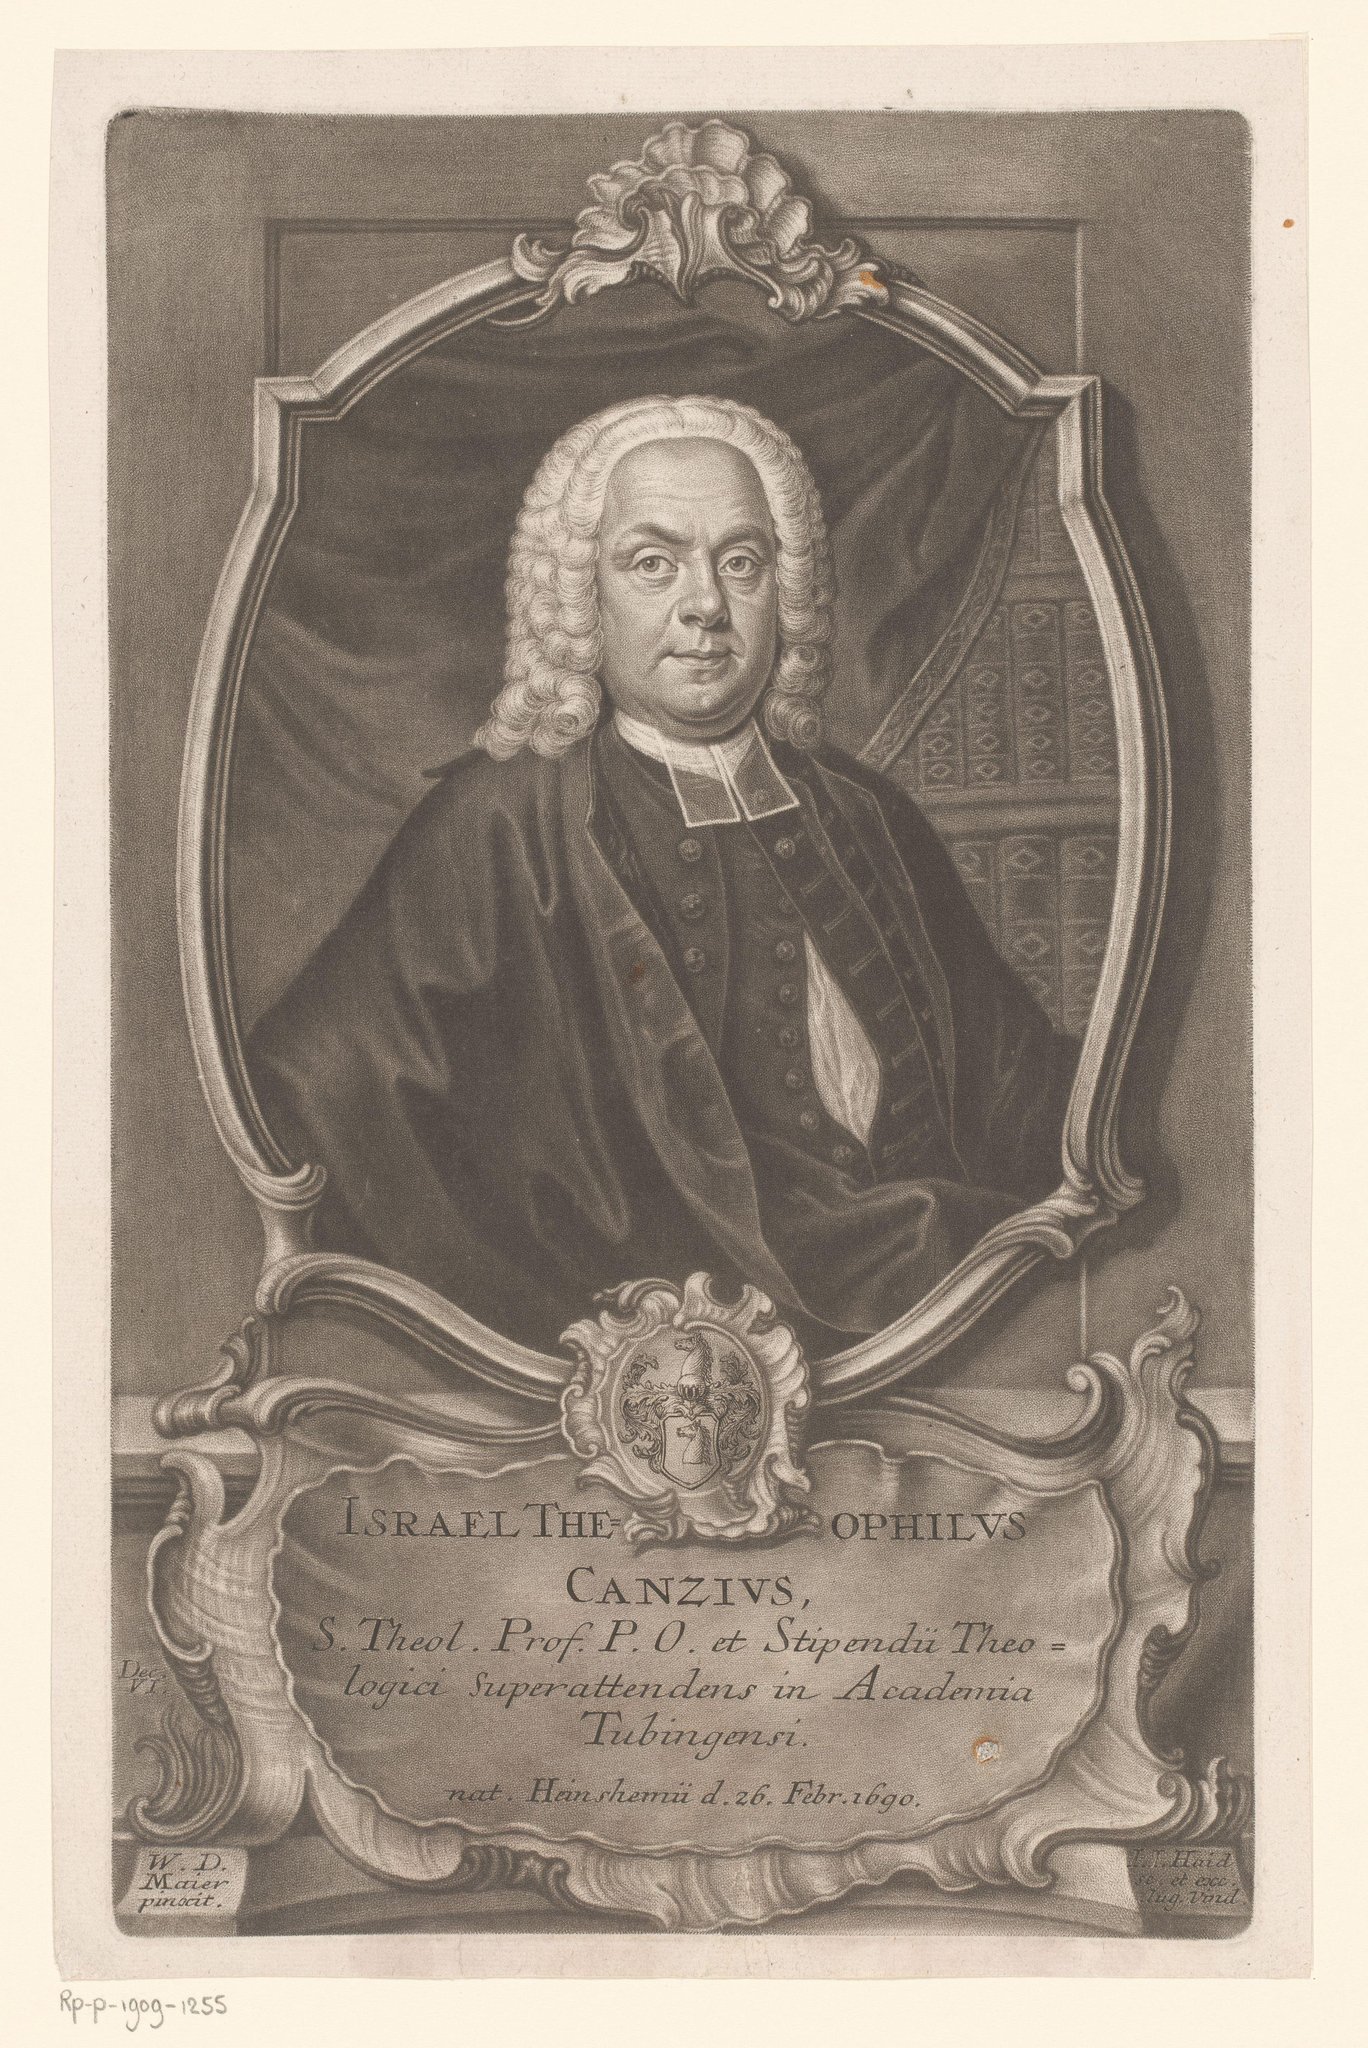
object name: print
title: Portret van Israel Gottlieb Canz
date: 1747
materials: paper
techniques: etching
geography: augsburg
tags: bookshelves, rocaille ornament, historical persons, ornament ~ cartouche, armorial bearing, heraldry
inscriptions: collector's mark: Lugt 2228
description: Prent gebruikt voor: Brucker, Jacob. Bildersal heutiges Tages lebender, durch Gelahrheit berühmter Schrifftsteller. Augsburg: Johann Jacob Haid, 1747.